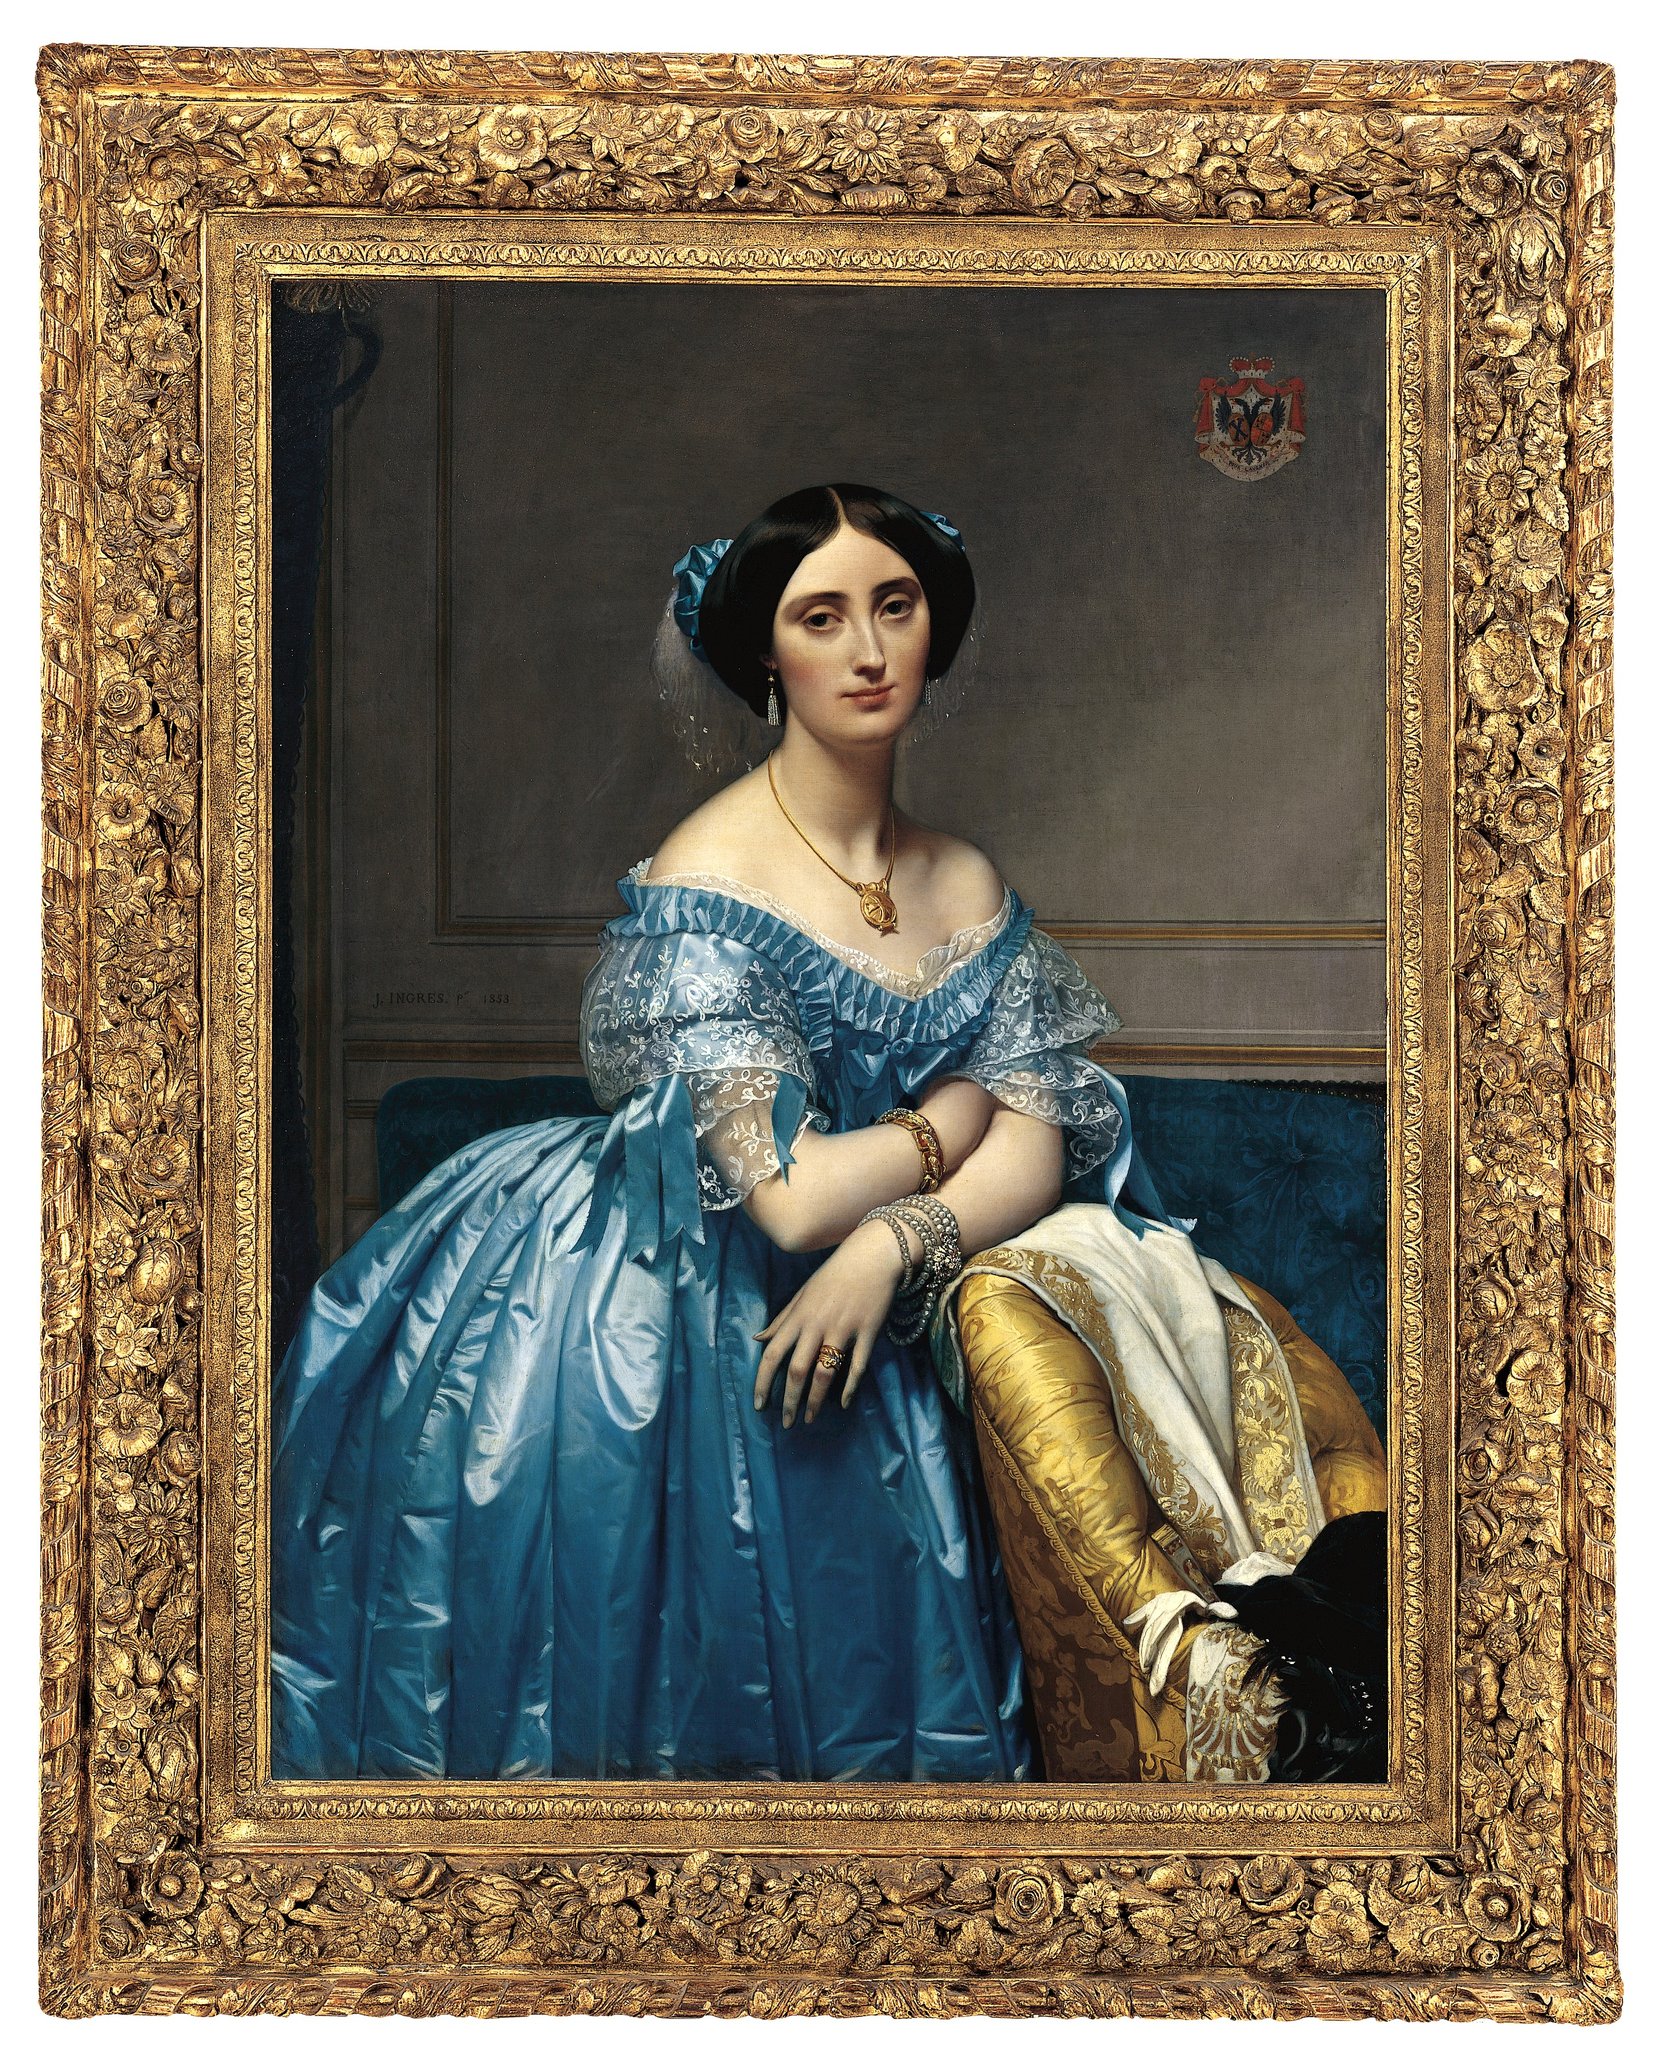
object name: frame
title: Louis XIII style Ovolo frame (for Ingres's Portrait of the Princesse de Broglie)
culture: french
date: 1950-1960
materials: gilt, wood, plaster